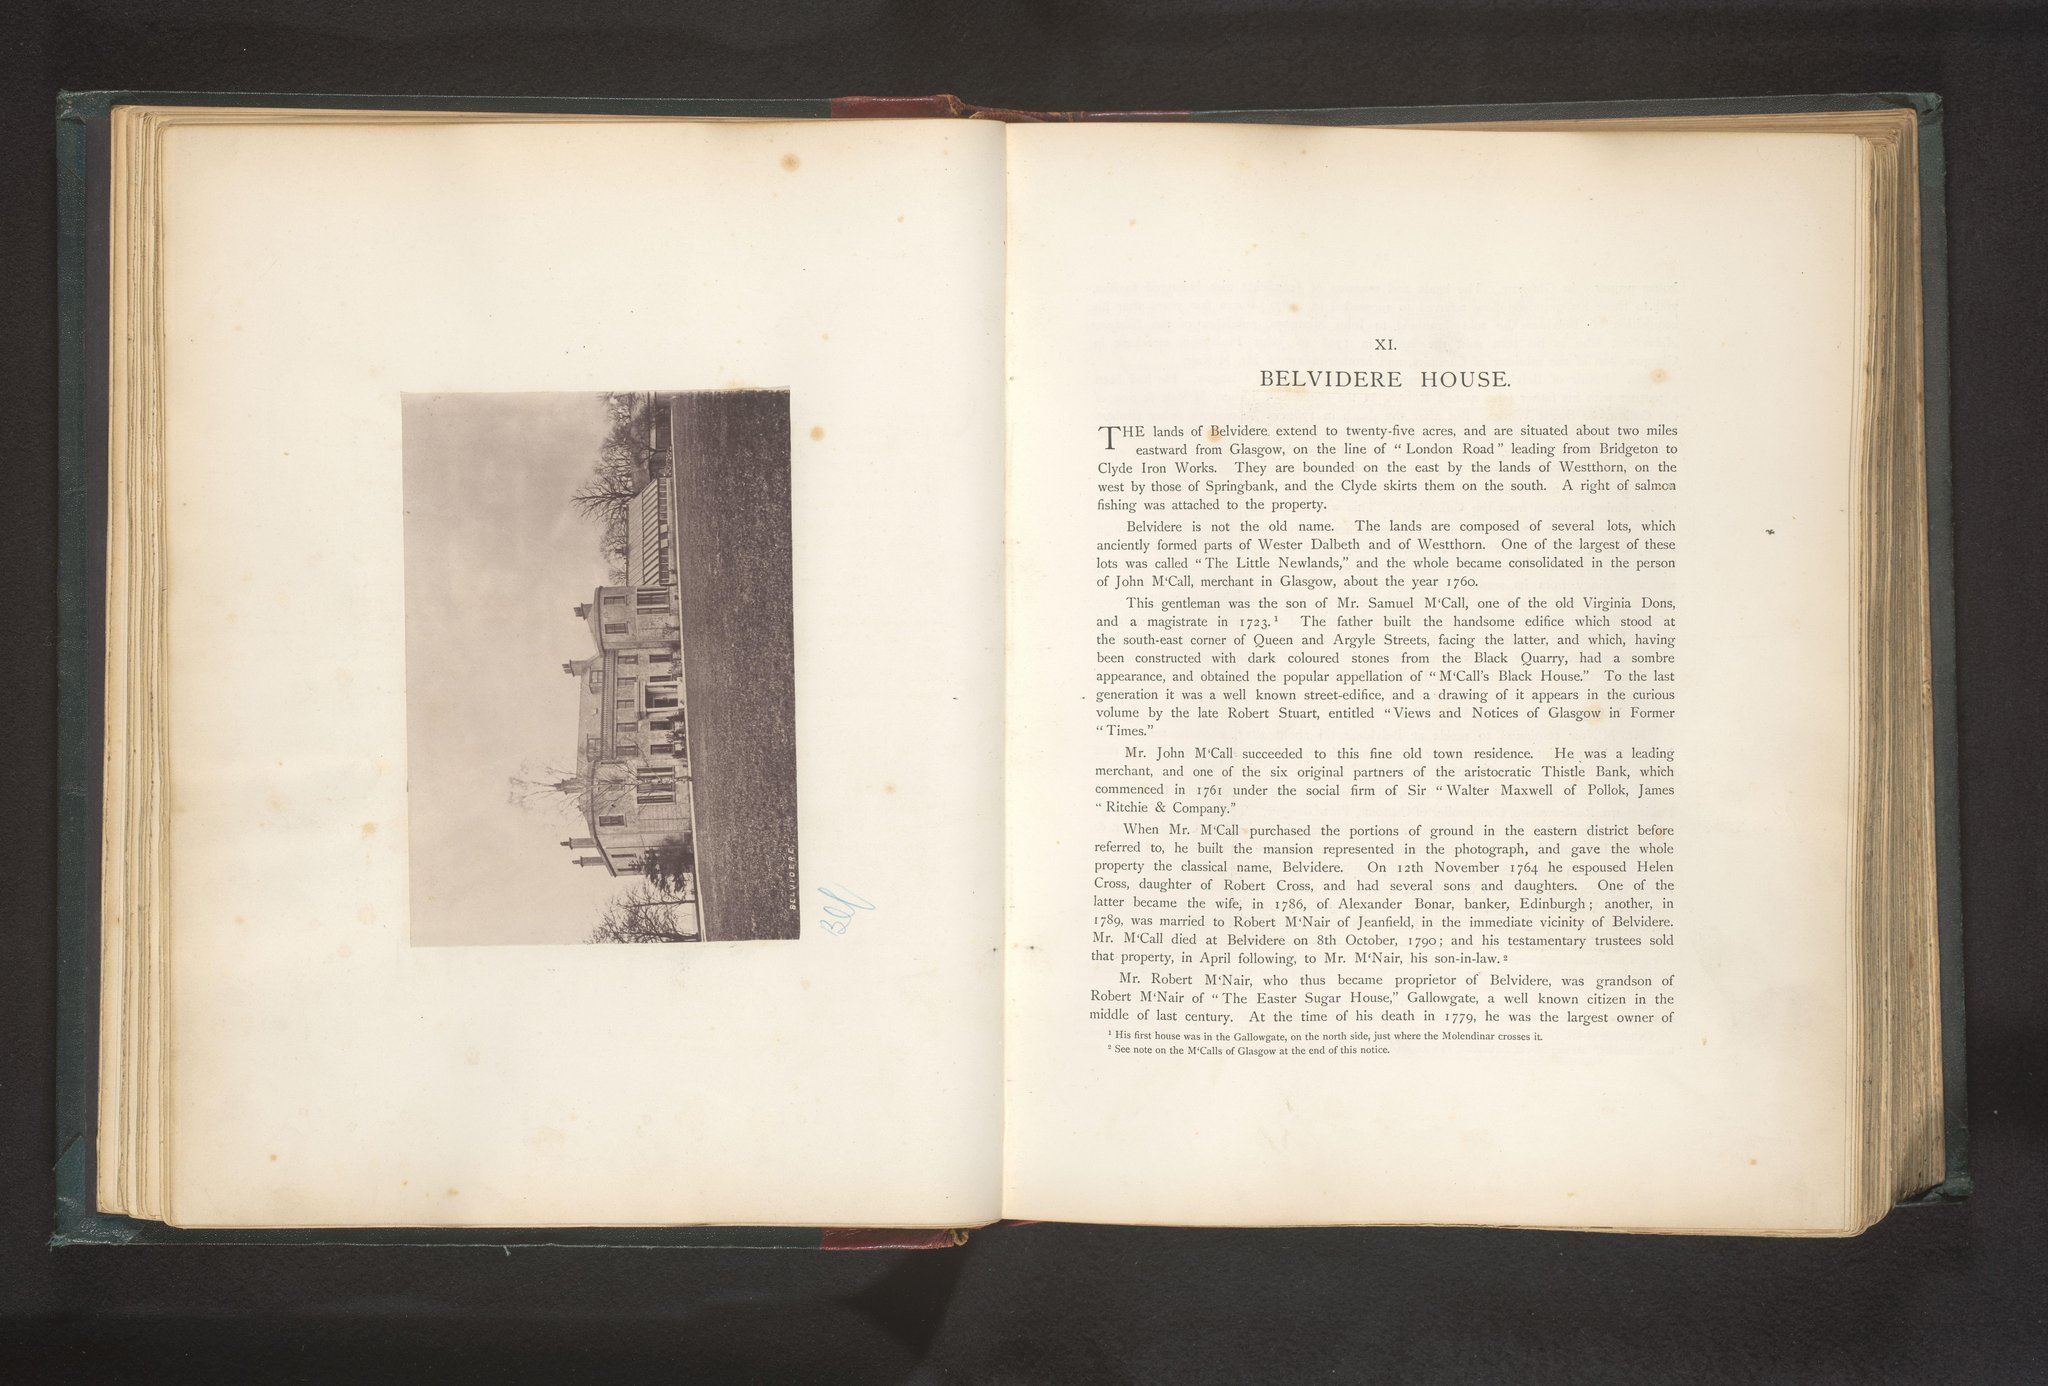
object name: page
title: Belvidere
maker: thomas annan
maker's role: fotograaf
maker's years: 1829-1887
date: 1868-1878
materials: paper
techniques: carbon print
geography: glasgow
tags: rural housing, e.g. country-house, villa, cottage, façade (of house or building)